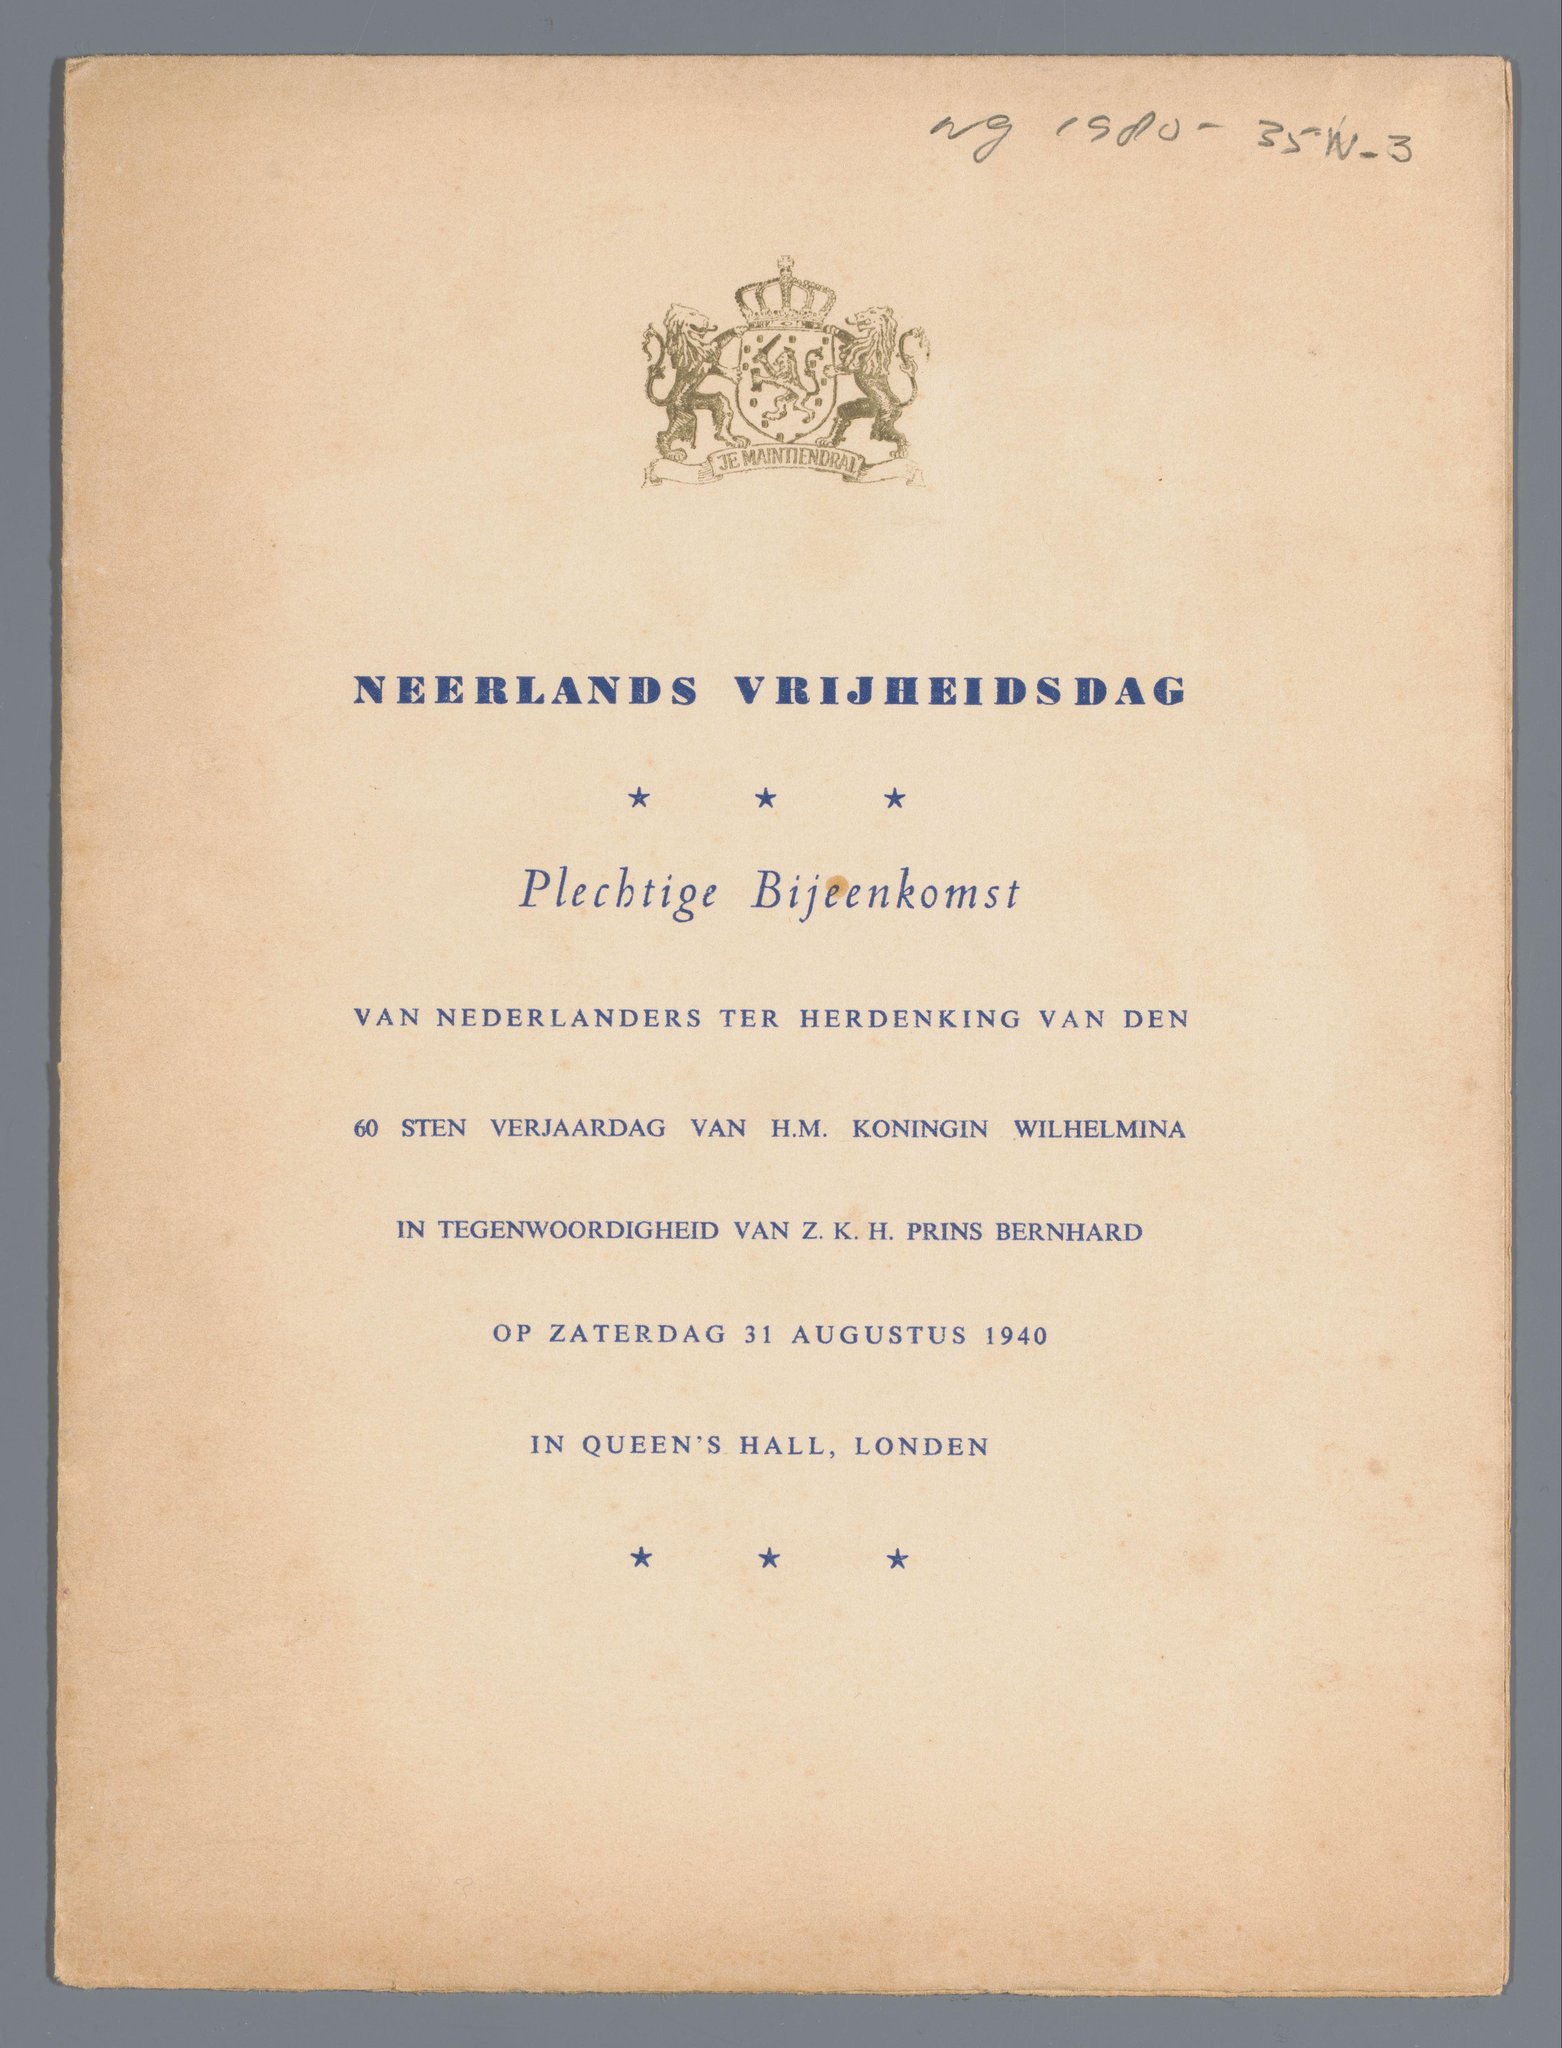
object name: leaflet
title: Neêrlands Vrijheidsdag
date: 1941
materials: paper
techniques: printing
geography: london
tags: london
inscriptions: date